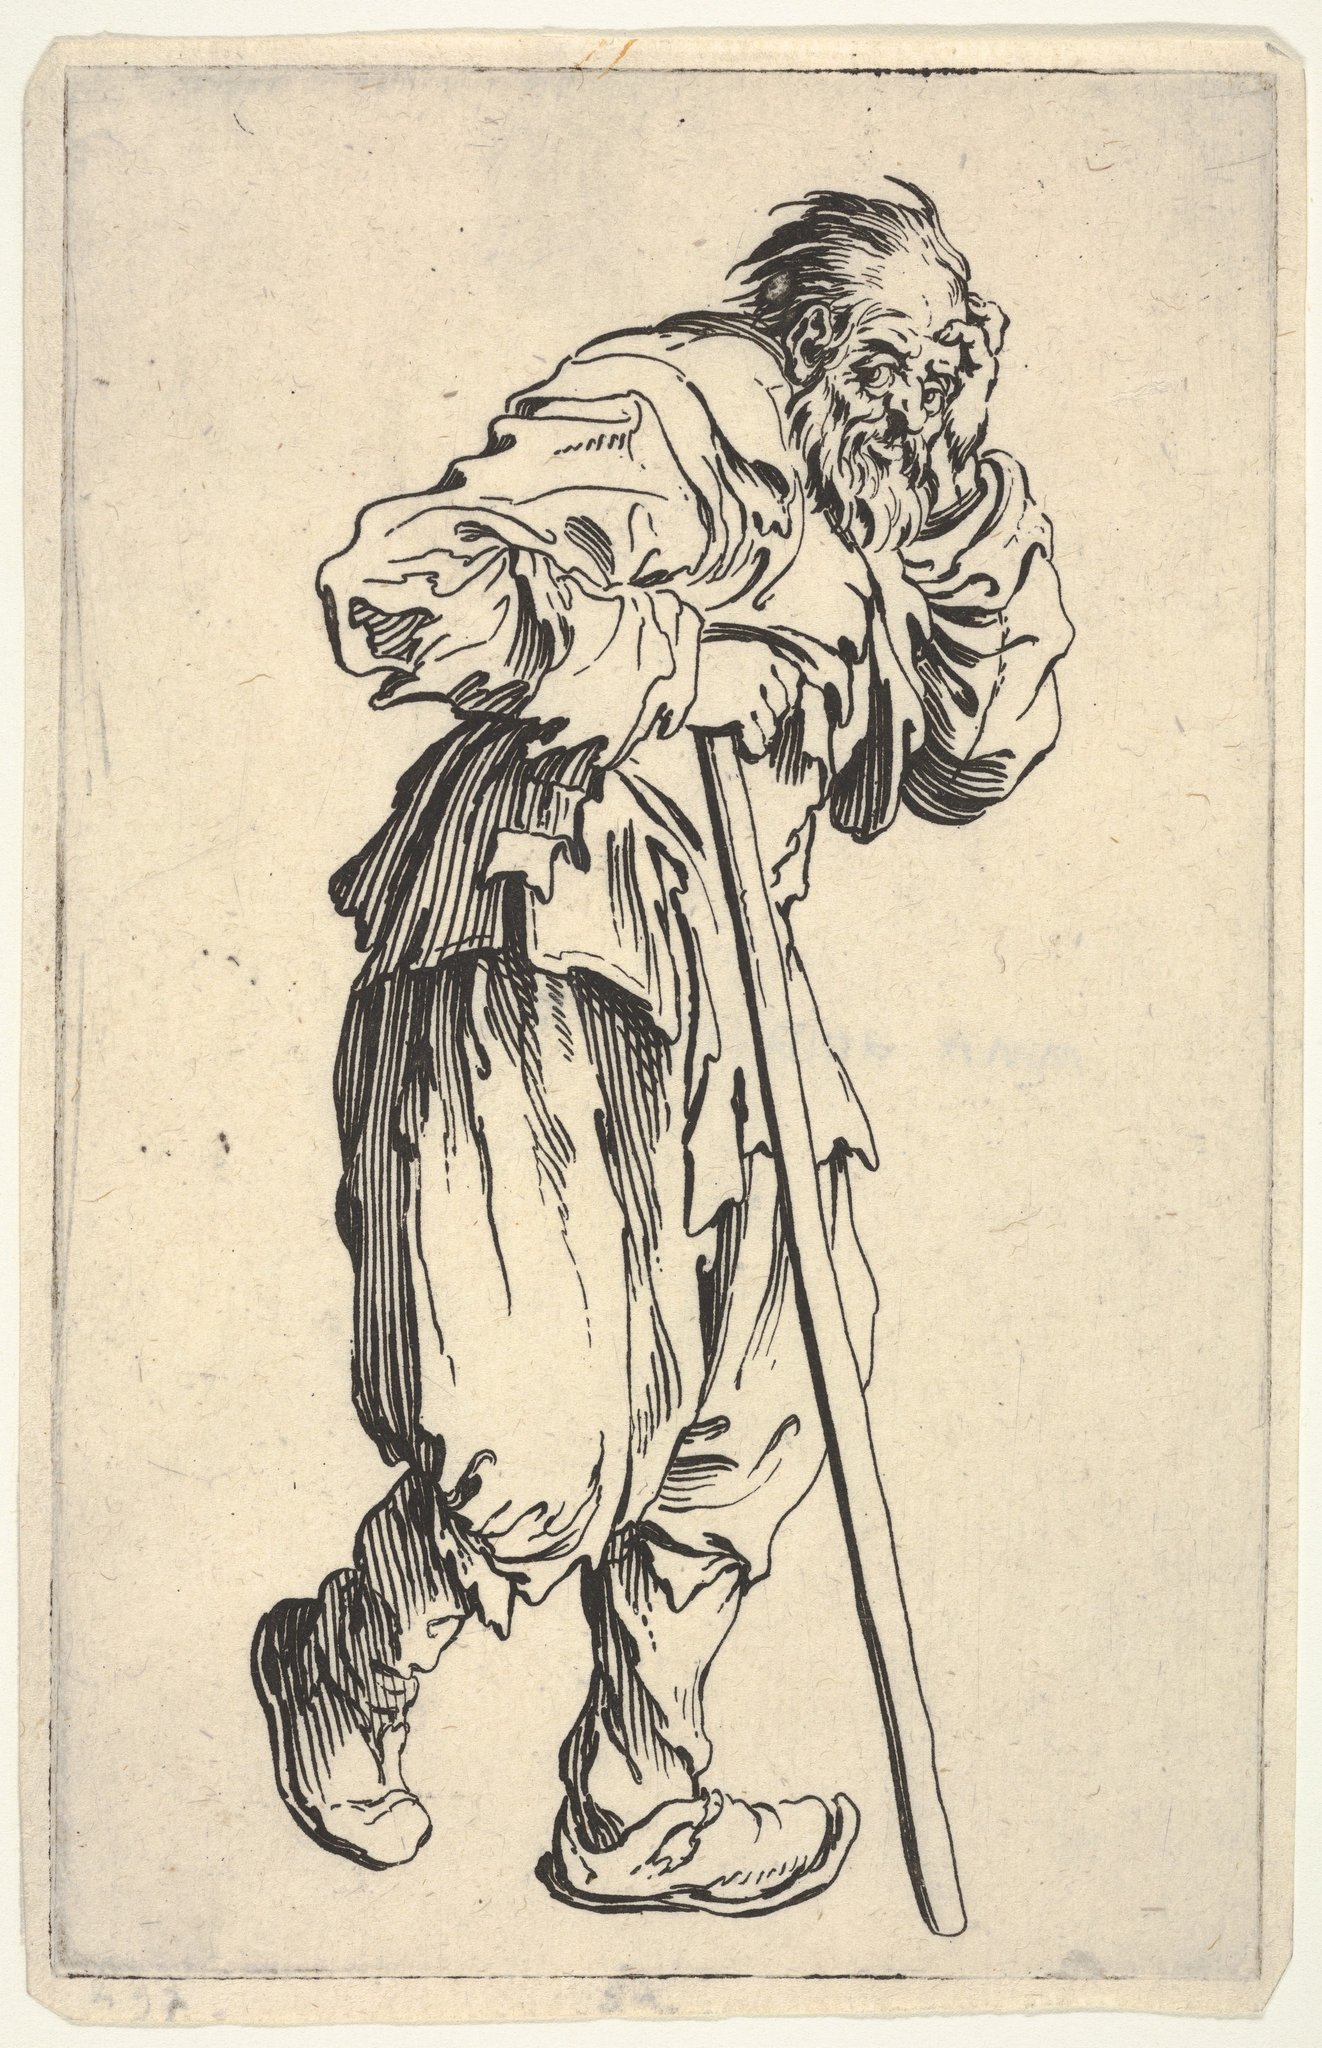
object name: print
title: Bearded man, dressed in rags, holding his head with one hand and a walking stick with the other, from "The Beggars" (Les Gueux)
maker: jacques callot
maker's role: artist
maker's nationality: french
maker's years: 1592-1635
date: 1622-1623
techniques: etching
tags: men